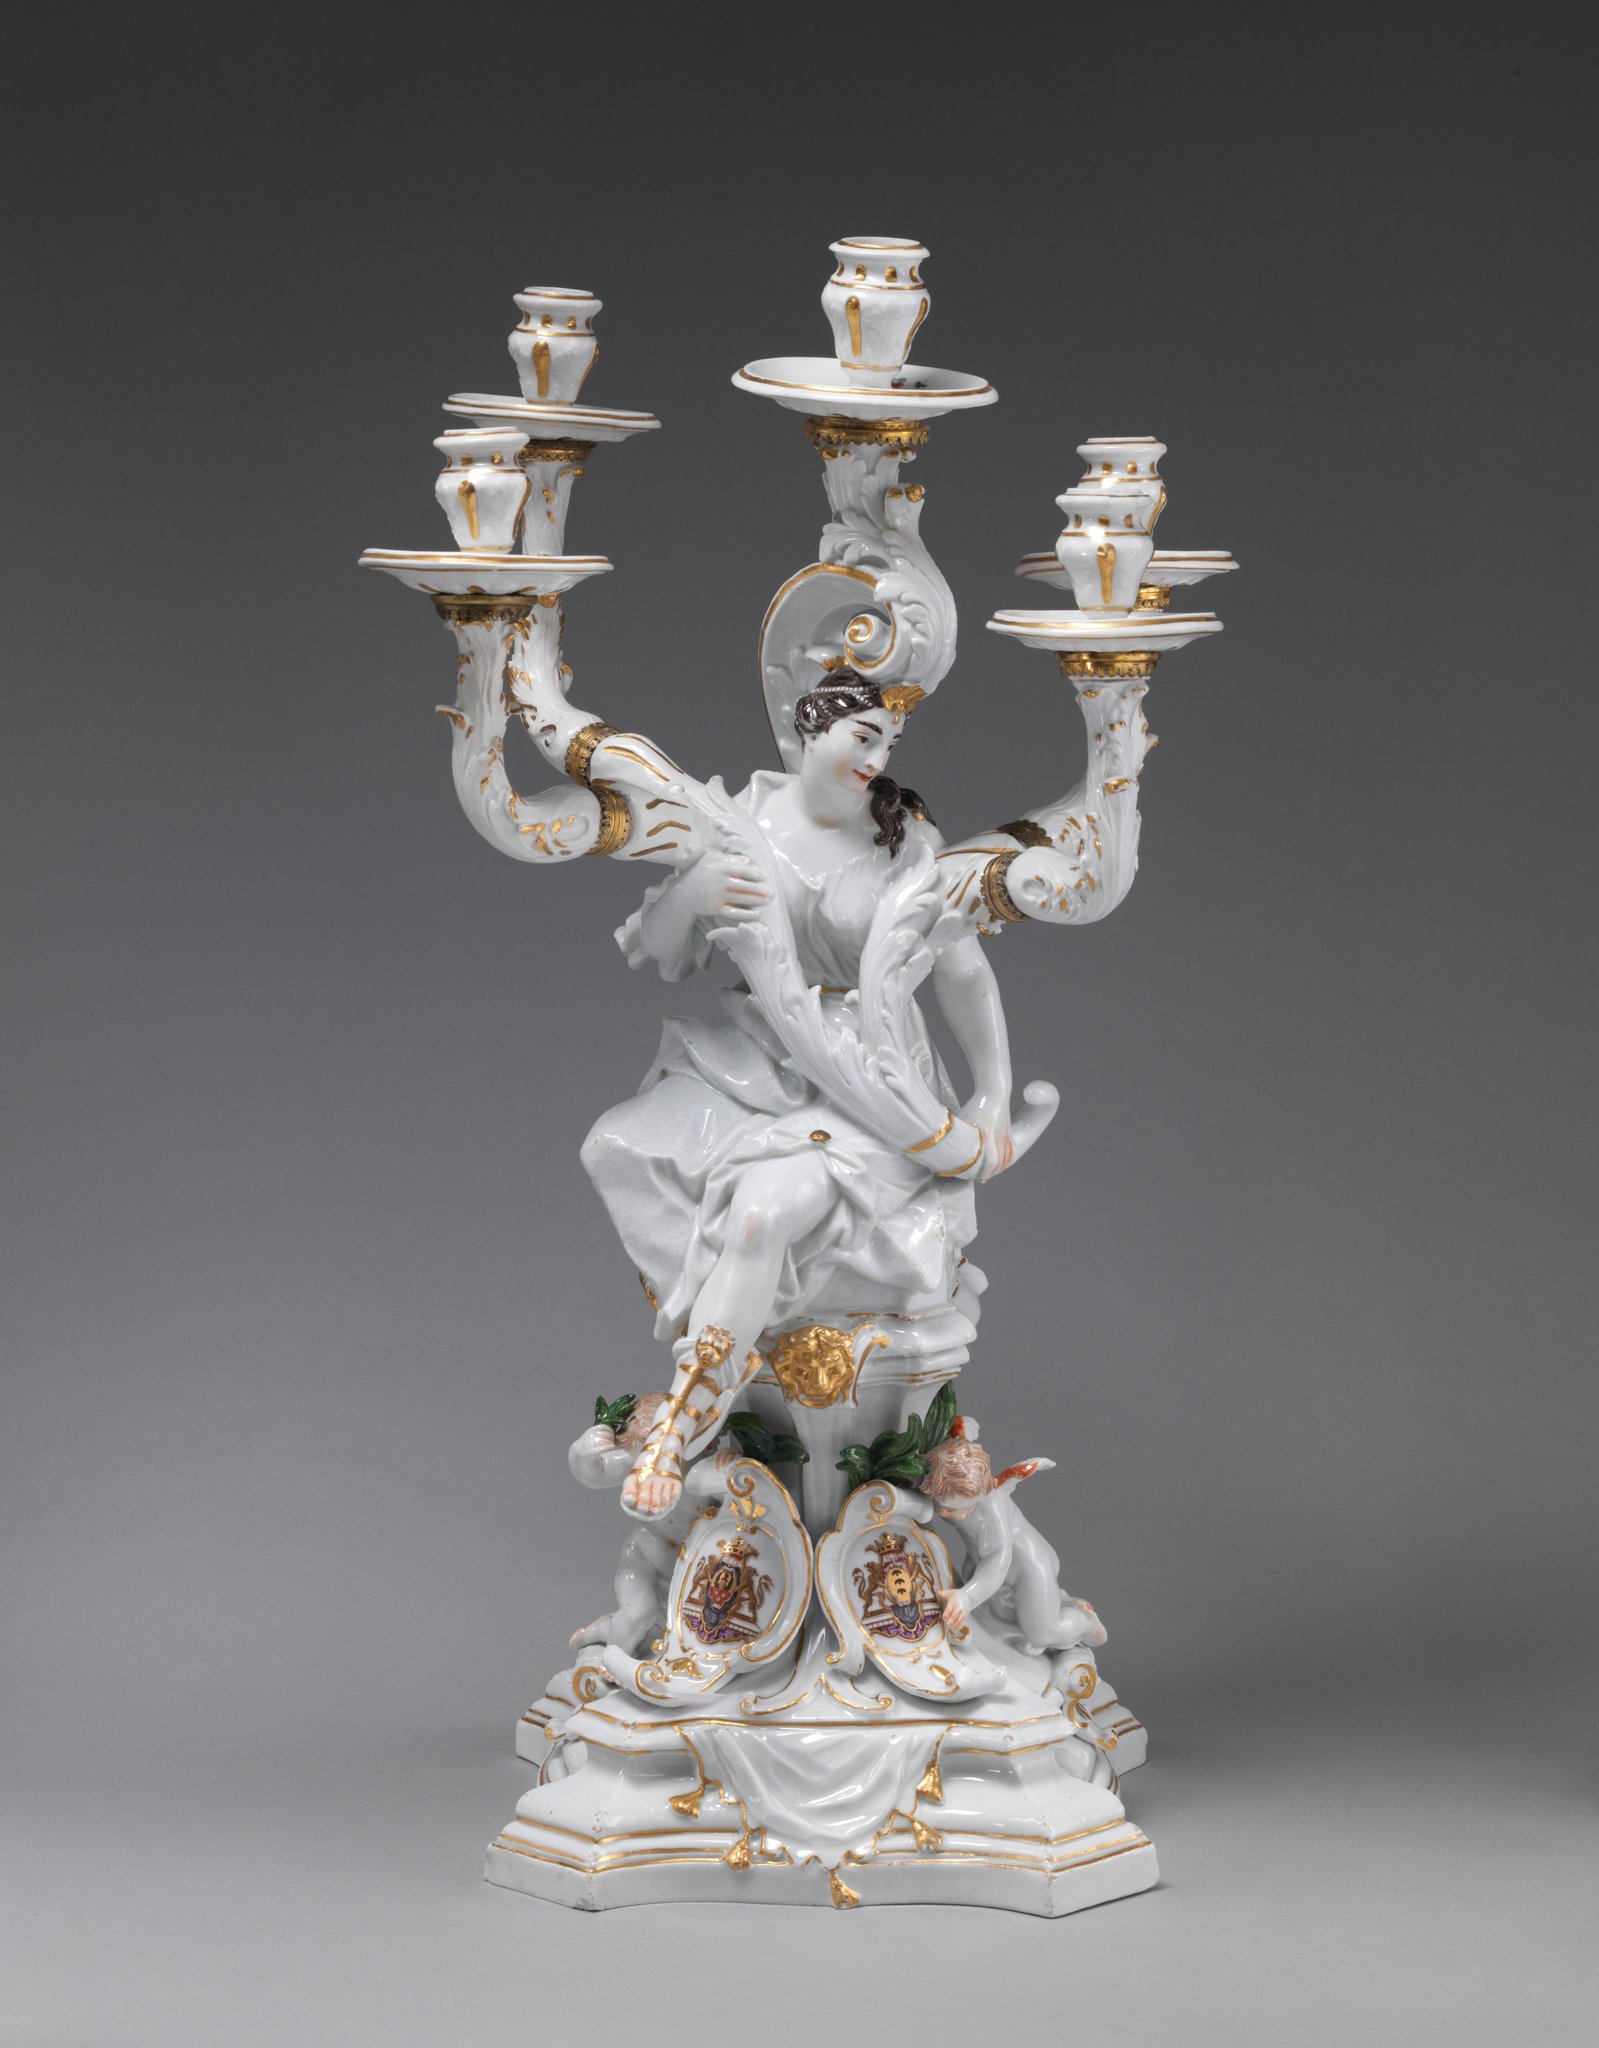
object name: candelabrum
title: Five-light candelabrum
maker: meissen manufactory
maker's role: manufactory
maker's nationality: german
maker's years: 1710-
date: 1736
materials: hard paste porcelain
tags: women,putti,coat of arms